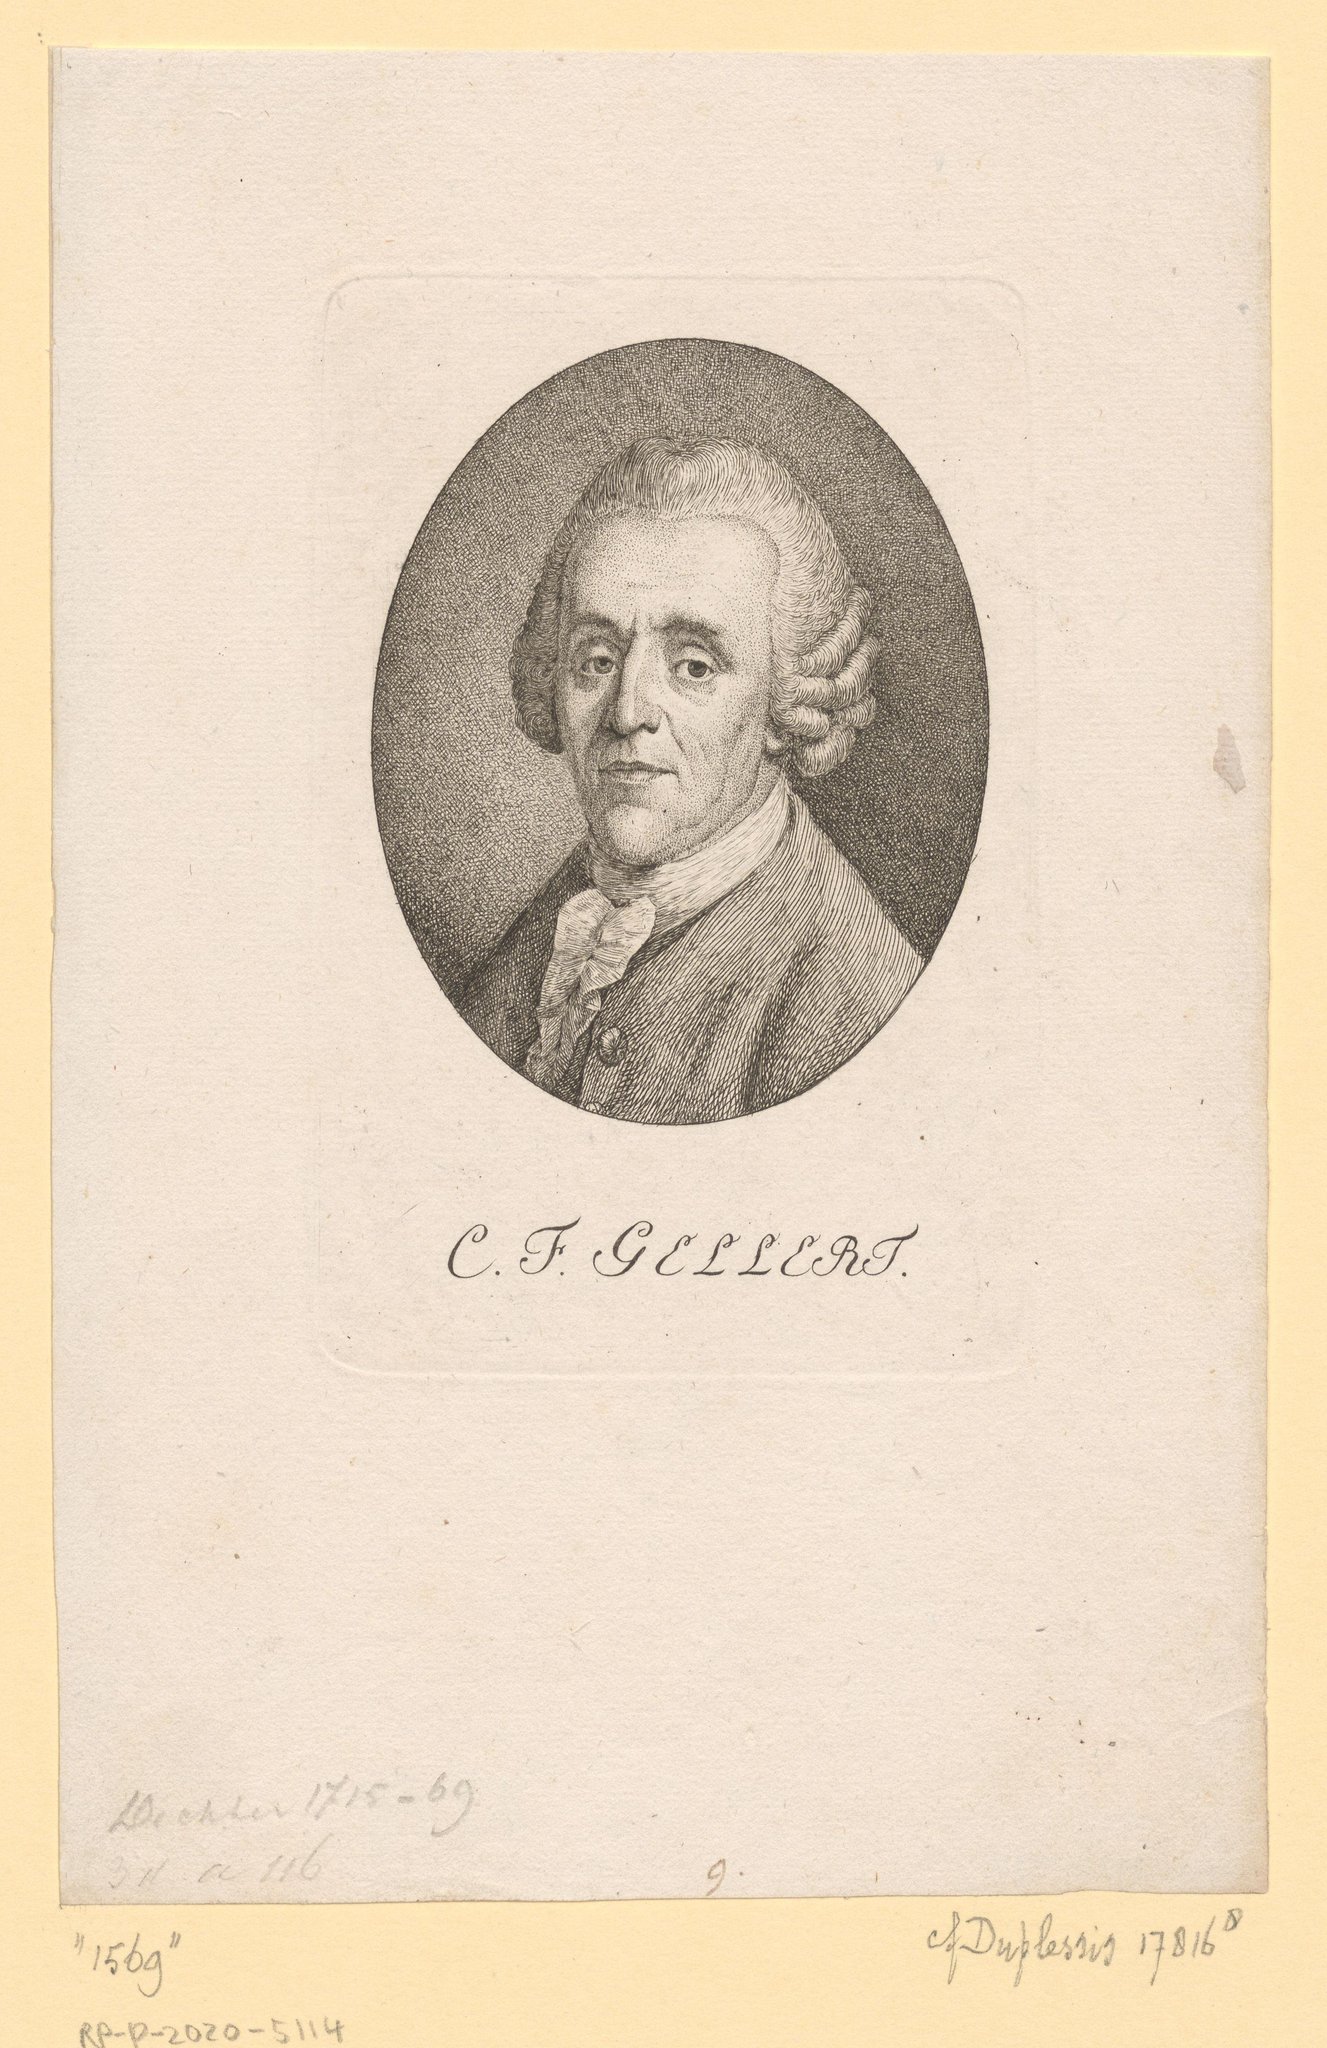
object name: print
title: Portret van Christian Furchtegott Gellert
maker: Anonymous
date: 1800-1900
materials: paper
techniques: engraving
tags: historical persons, writer, poet, author